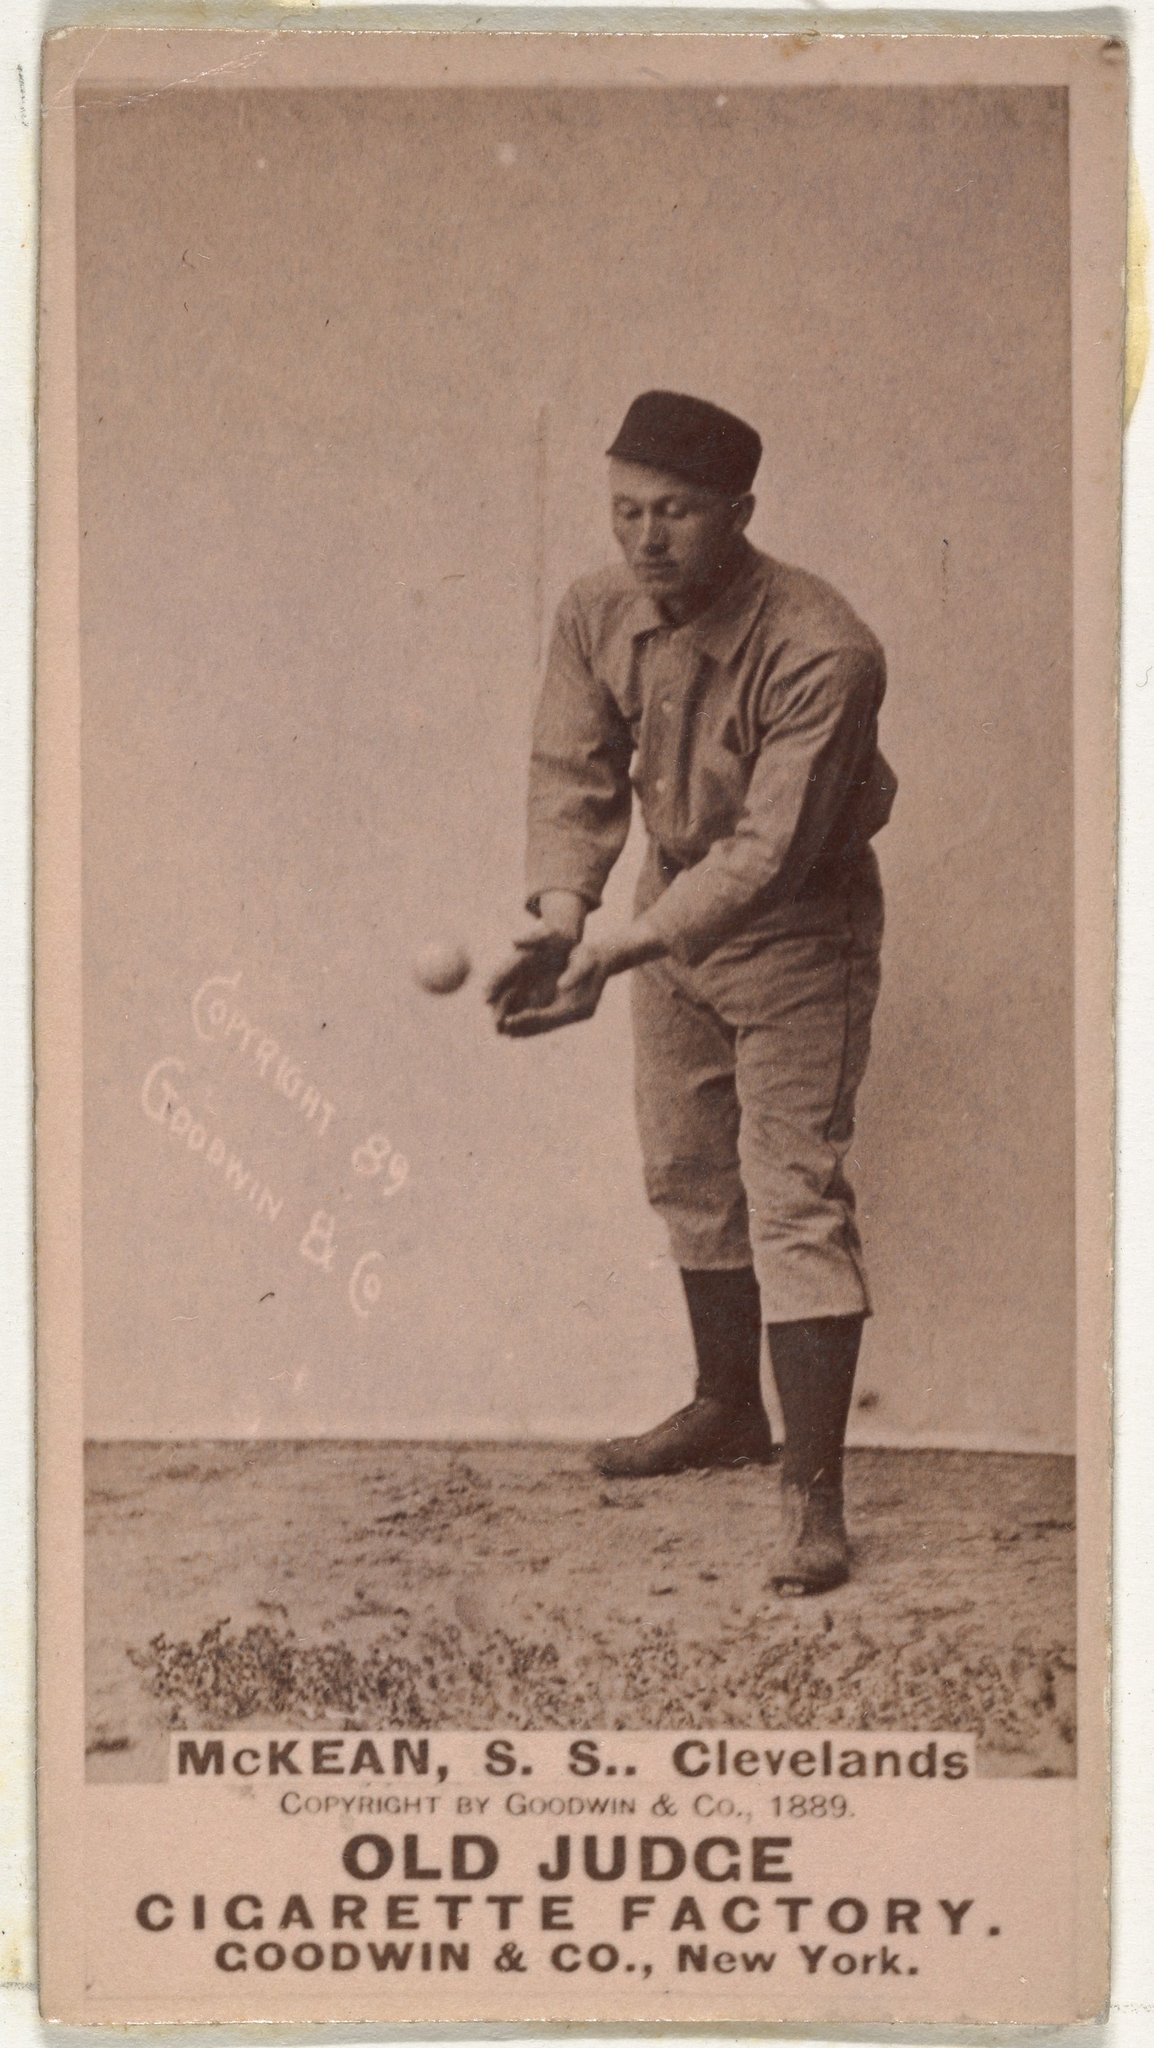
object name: baseball card, photograph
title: Edwin John "Ed" McKean, Shortstop, Cleveland, from the Old Judge series (N172) for Old Judge Cigarettes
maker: goodwin & company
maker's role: publisher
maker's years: 1850-1950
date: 1889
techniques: albumen silver print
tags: men,portraits,baseball,athletes